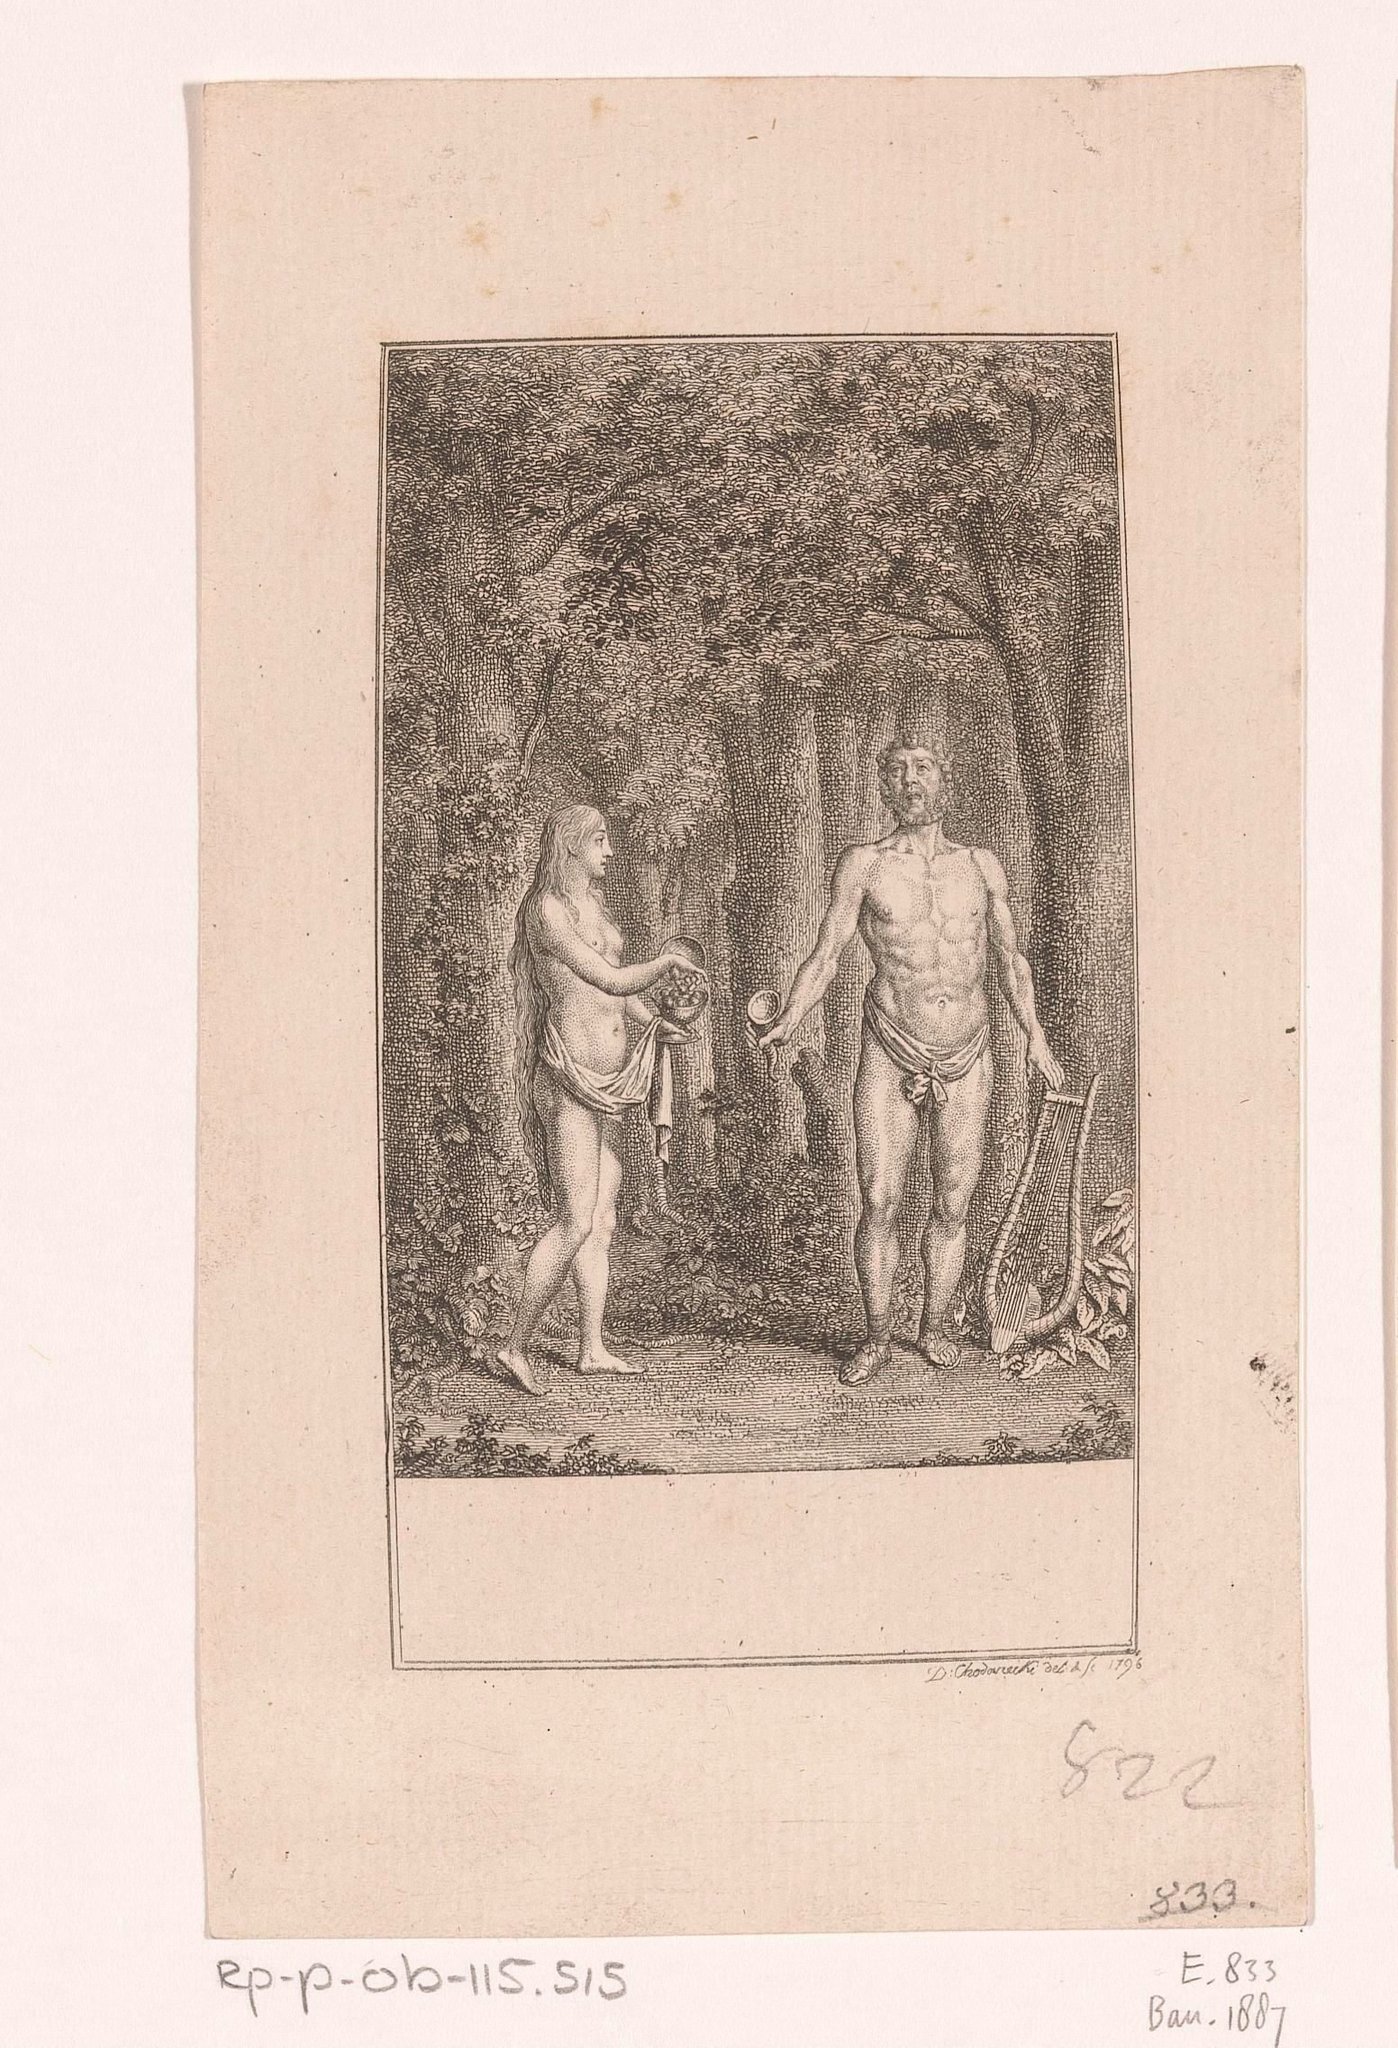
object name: print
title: Bragur en Idunna in het bos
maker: daniel nikolaus chodowiecki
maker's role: draughtsman, print maker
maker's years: 1726-1801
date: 1796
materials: paper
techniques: etching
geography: berlin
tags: representations ~ gods, demi-gods, heroes etc. (germanic and scandinavian religions), harp, forest, wood, nude with covered genitals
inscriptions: collector's mark: Lugt 2228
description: Latere staat gebruikt voor: Gräter, Friedrich David. Bragur. Ein literarisches Magazin der Deutschen und Nordischen Vorzeit. Leipzig: Heinrich Gräff, 1796.